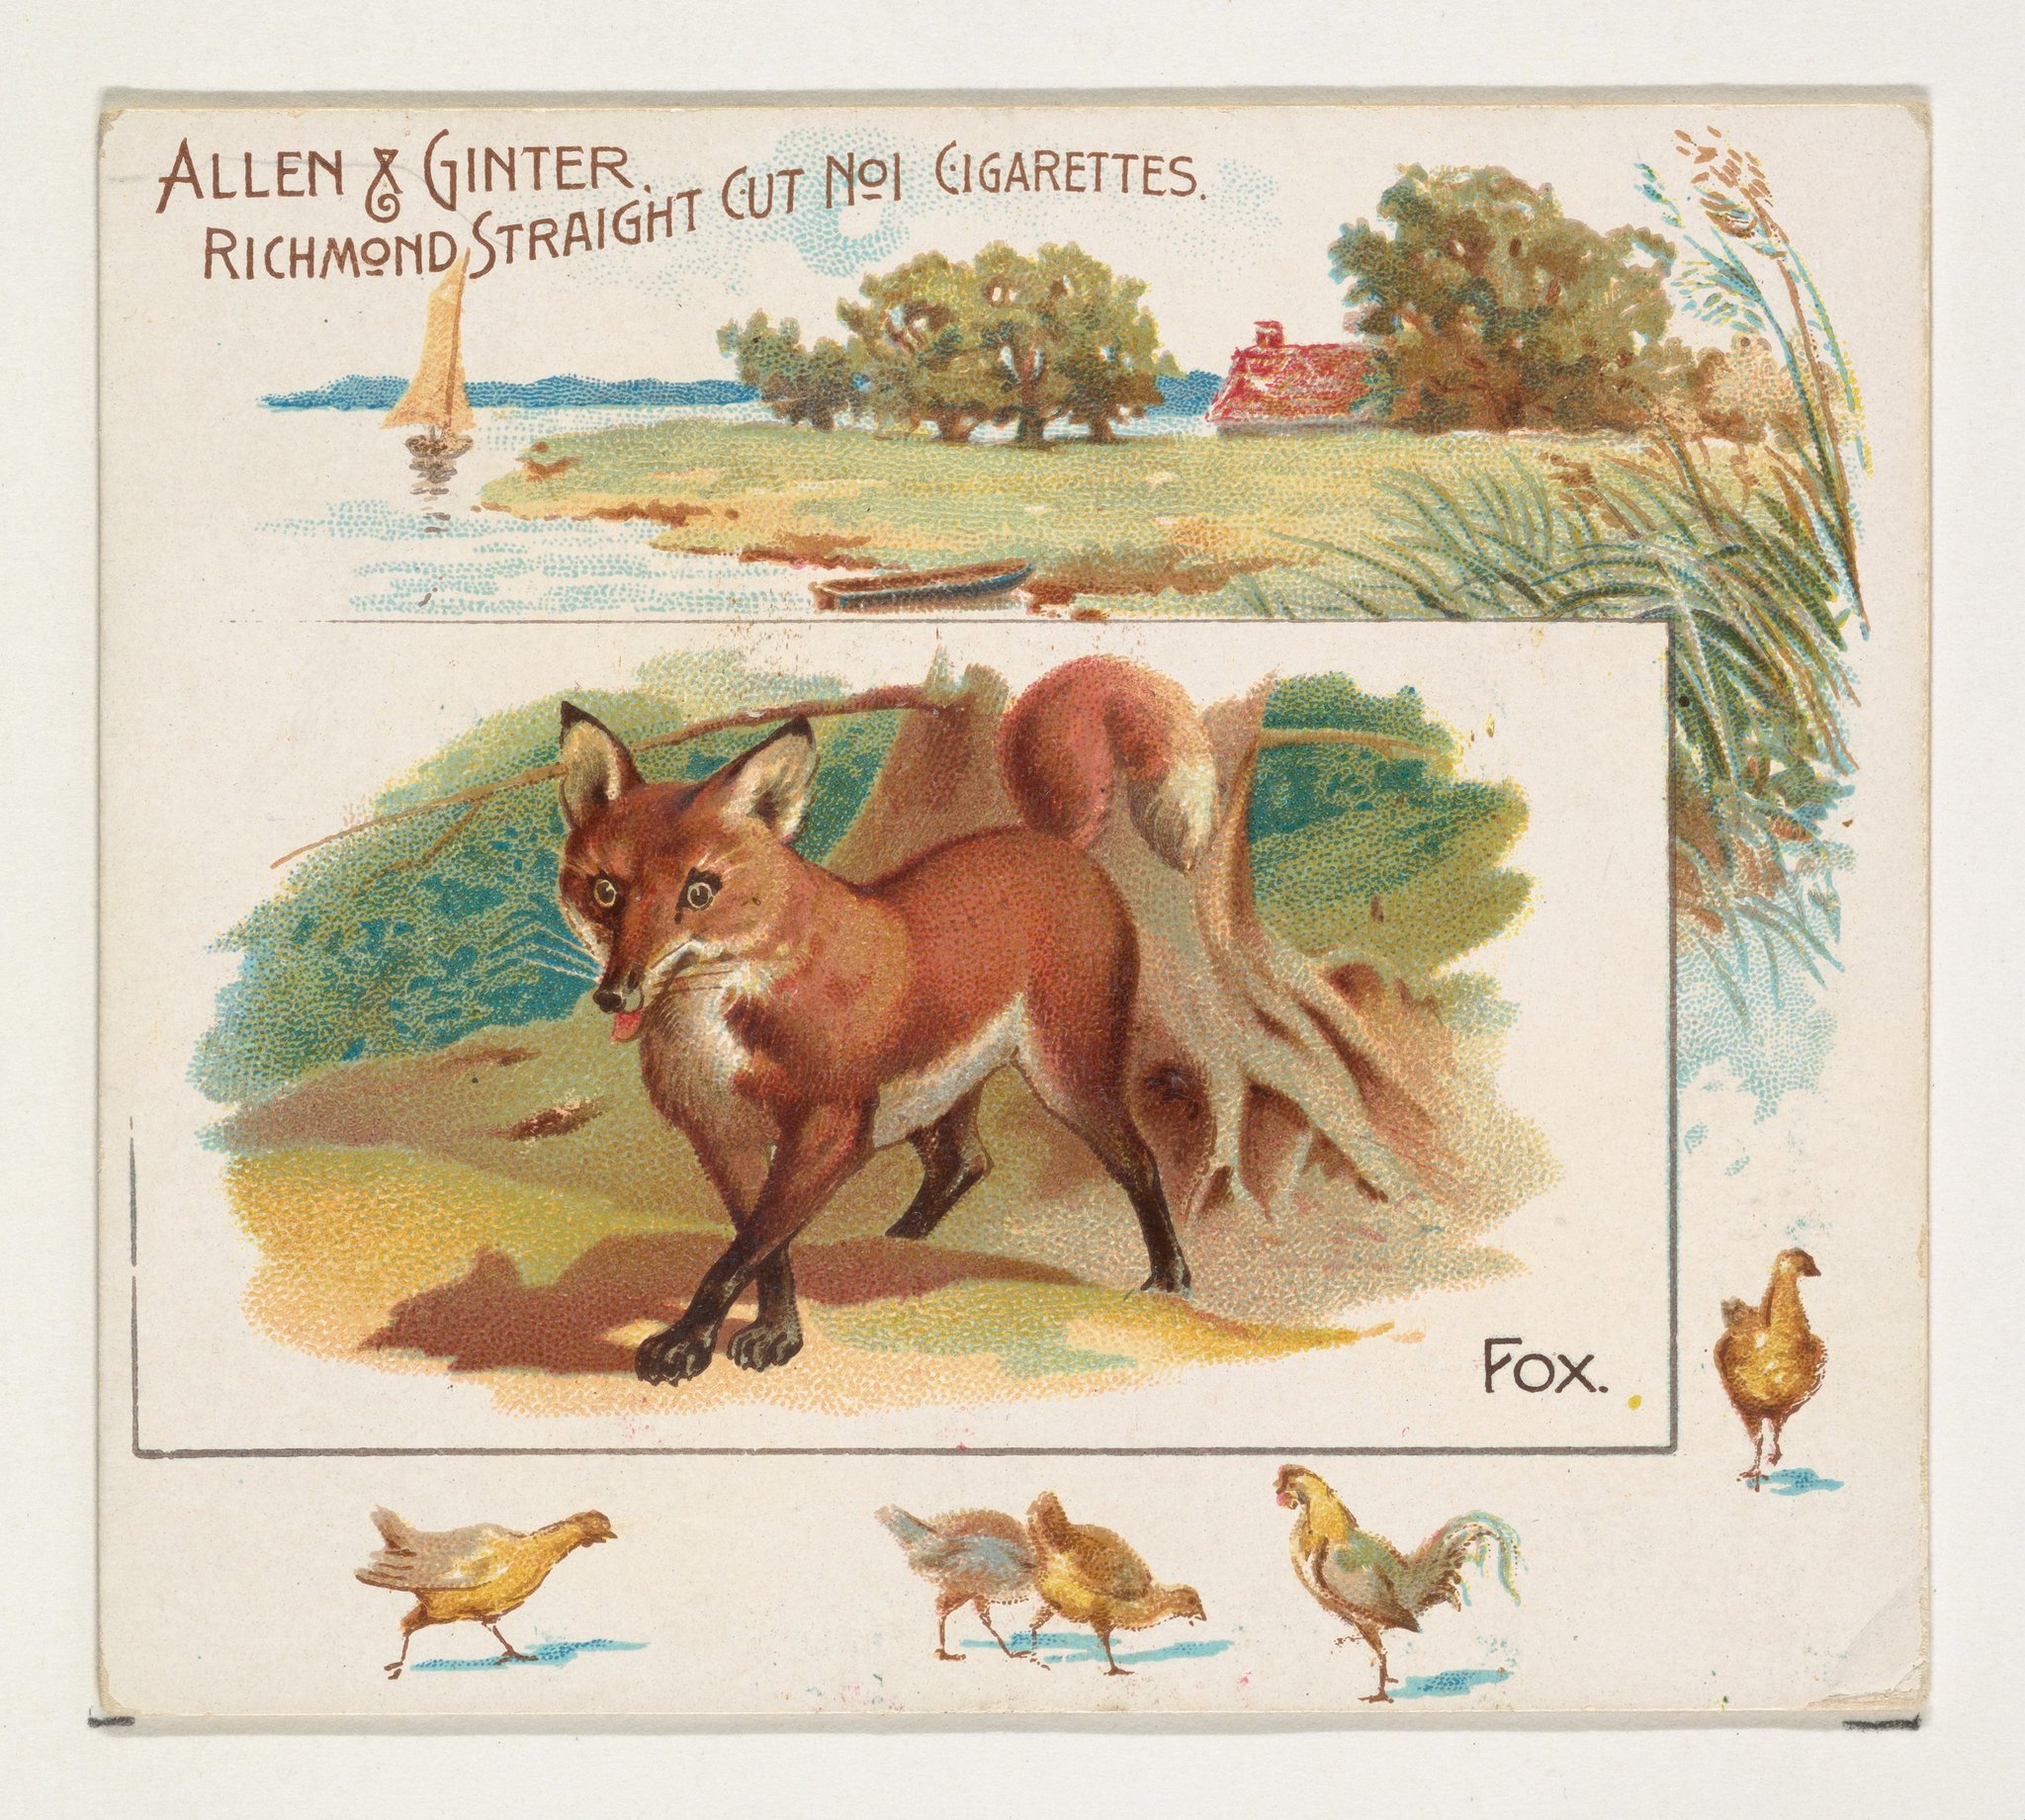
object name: print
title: Fox, from Quadrupeds series (N41) for Allen & Ginter Cigarettes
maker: allen & ginter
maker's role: publisher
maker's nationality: american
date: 1890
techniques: color lithograph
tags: foxes